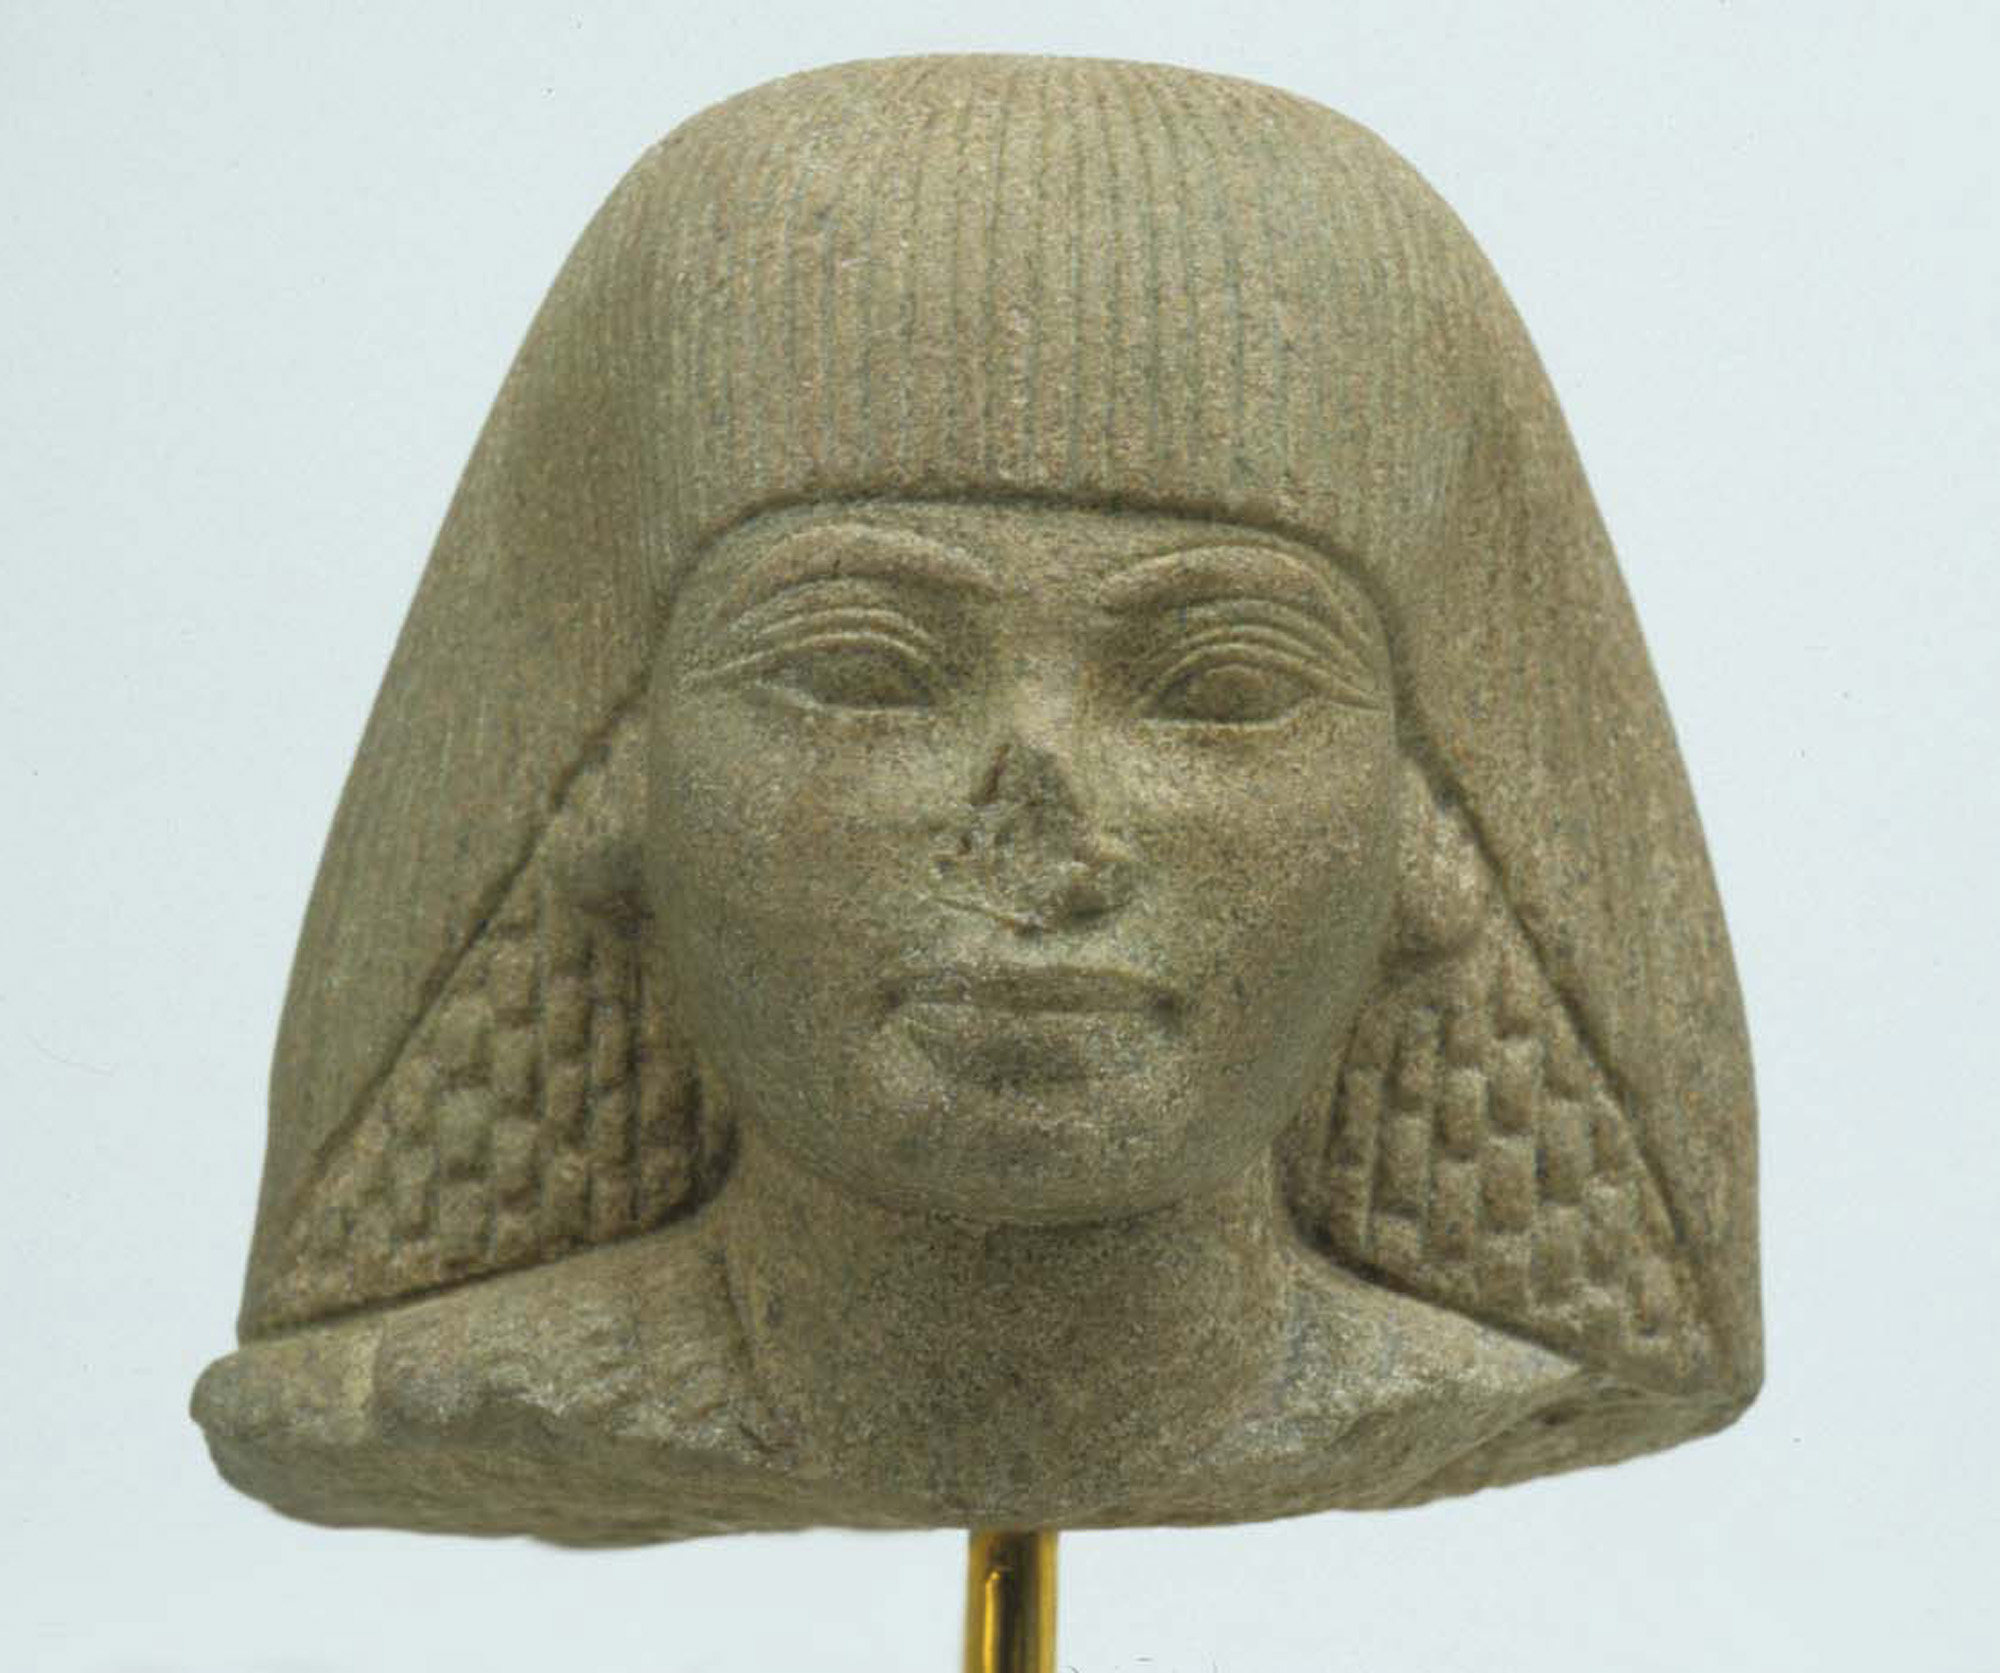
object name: head, official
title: Head of an Official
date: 1390-1352 BCE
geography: egypt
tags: heads,women